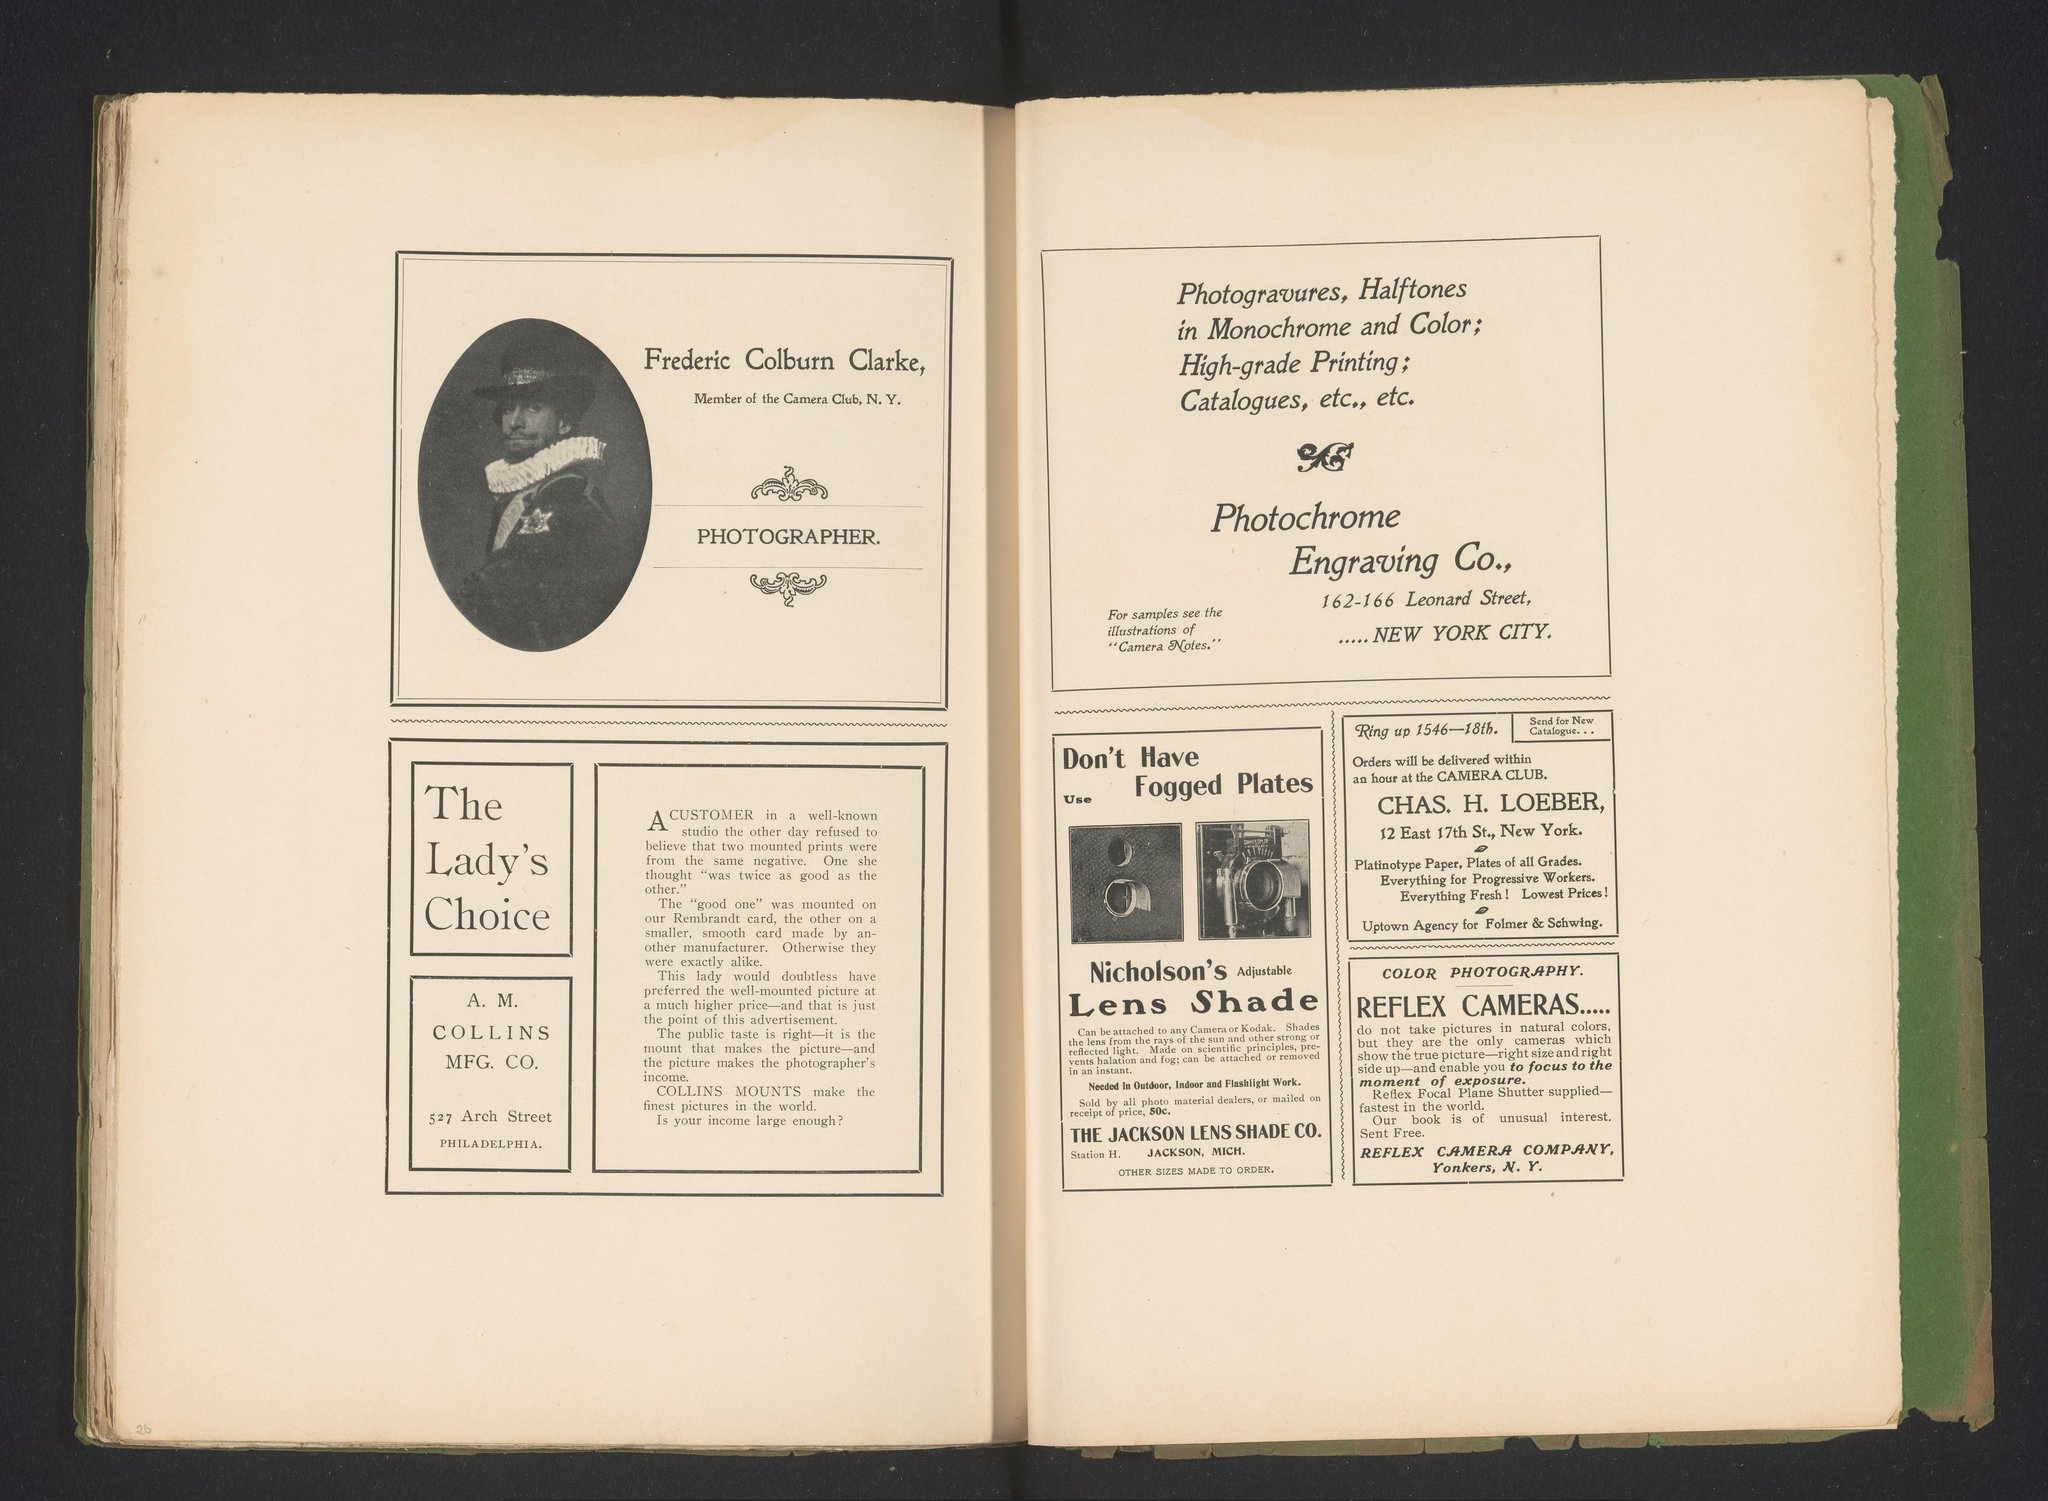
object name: page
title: Detail van de voorkant van een camera met zonnekap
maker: Anonymous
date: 1896-1901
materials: paper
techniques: autotype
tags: camera ~ photography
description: Prent in katern advertenties achterin boek. Prent is onderdeel van een advertentie van The Jackson Lens Shade Co.